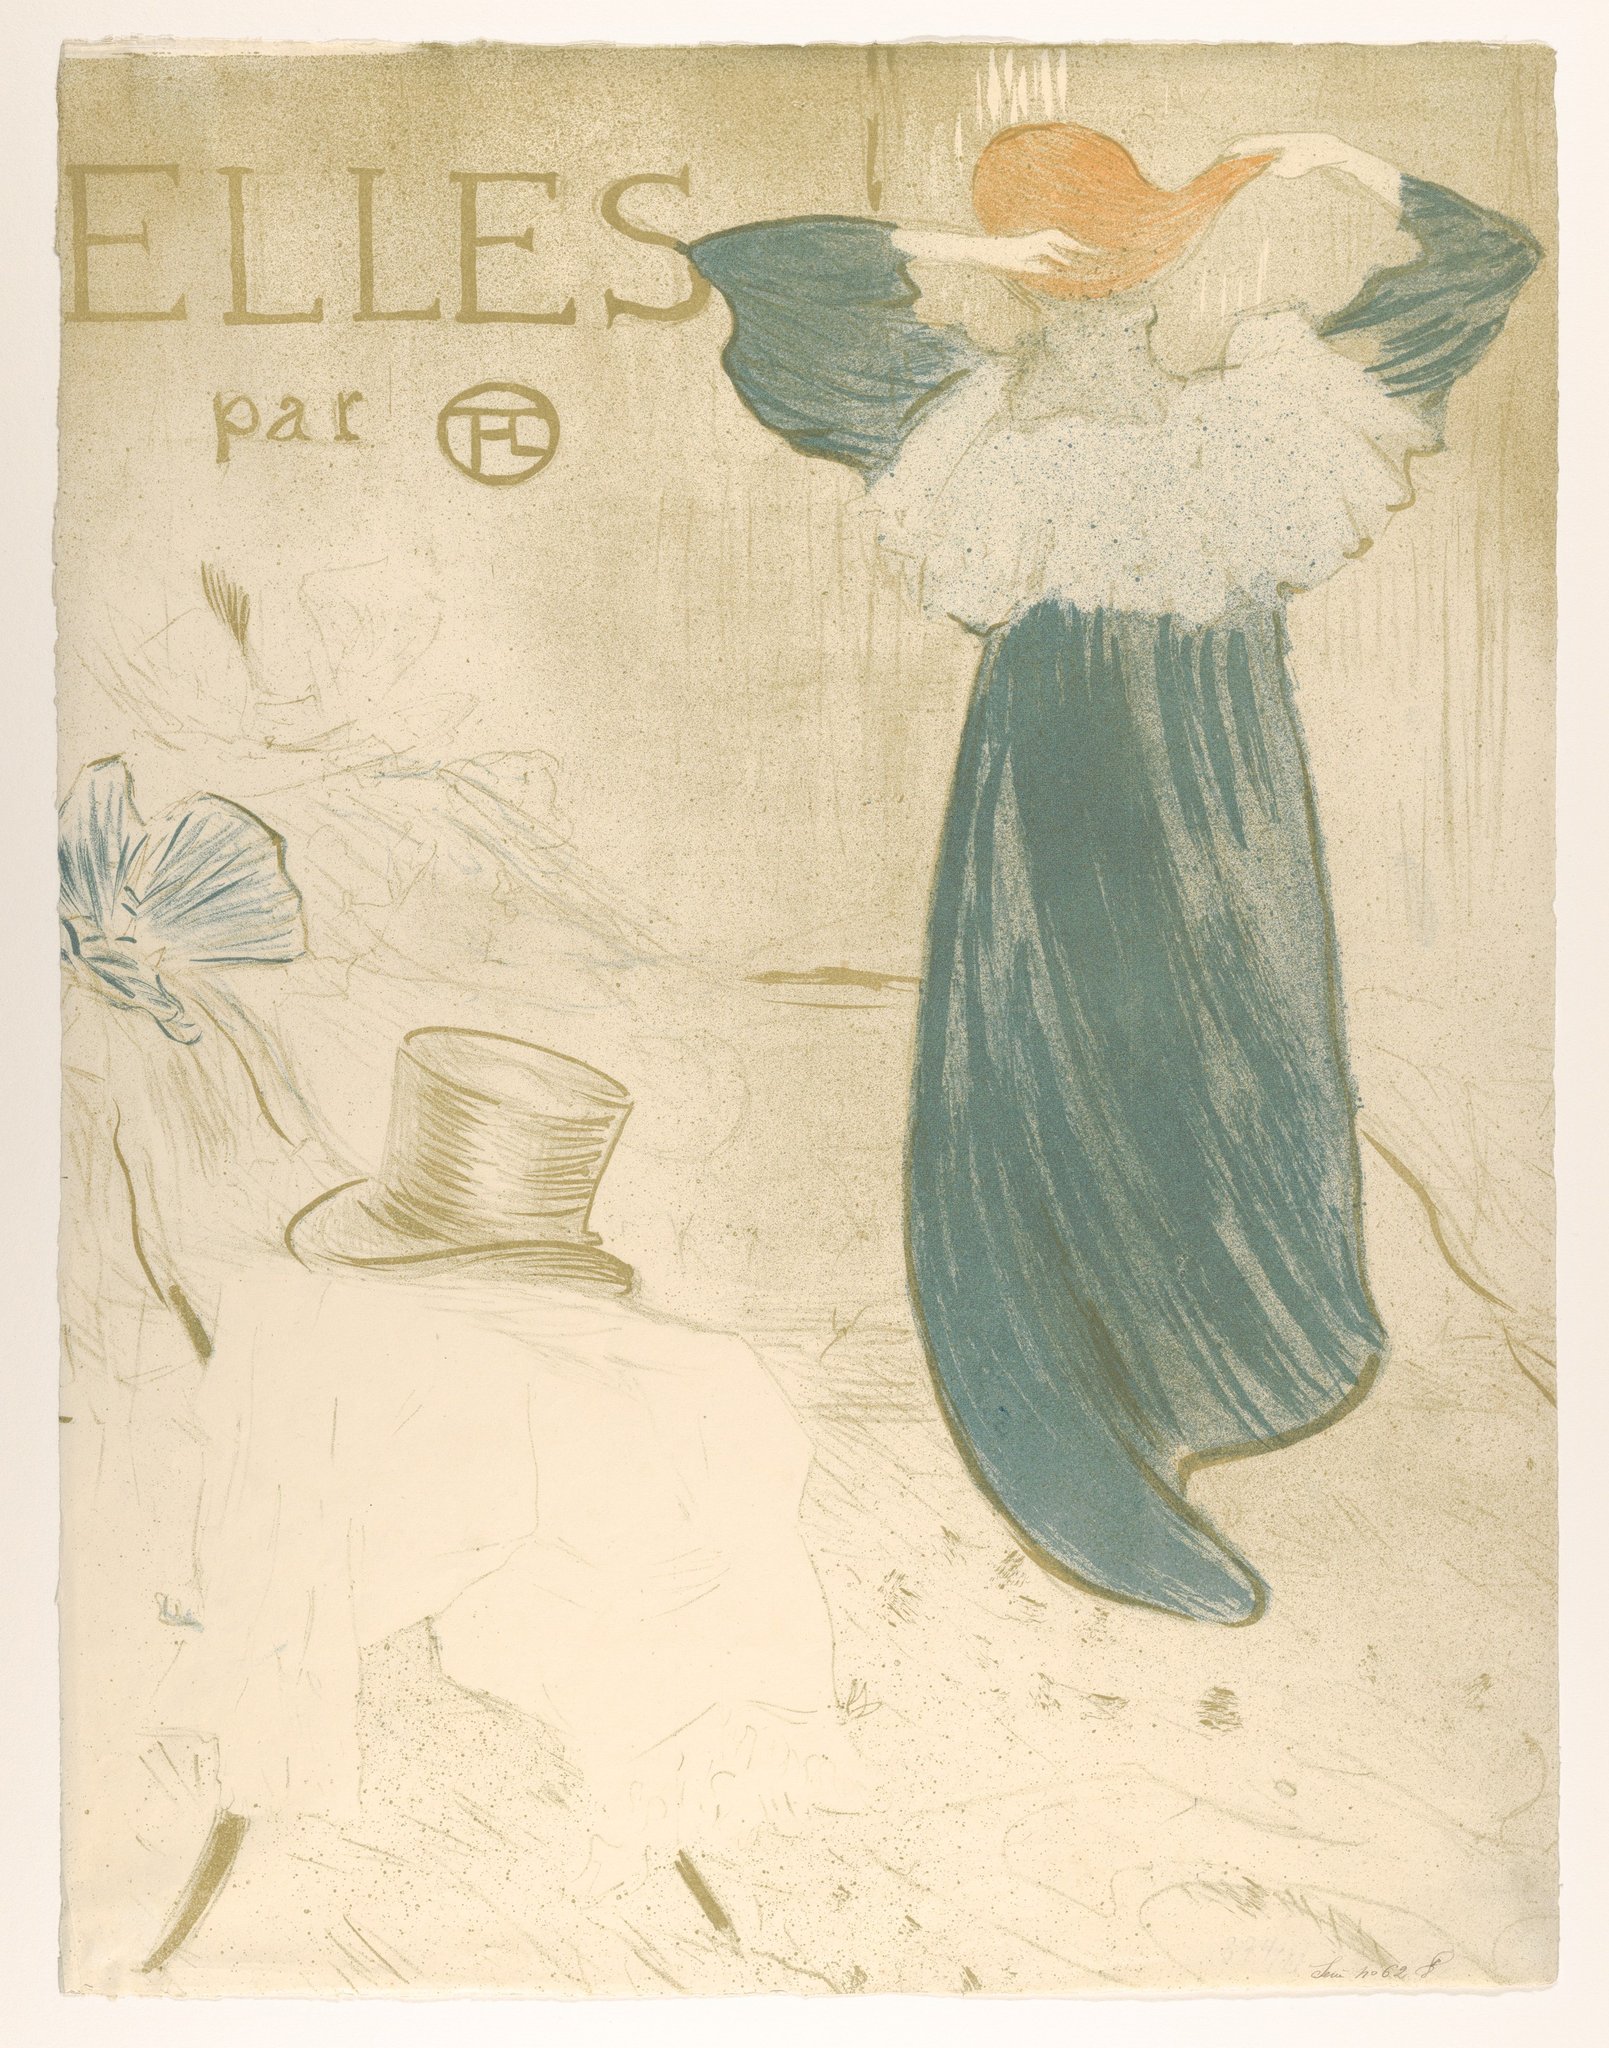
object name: print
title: Elles (portfolio cover)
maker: henri de toulouse-lautrec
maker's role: artist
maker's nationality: french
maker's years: 1864-1901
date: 1896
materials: crayon, paper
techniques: brush, lithograph, printing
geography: france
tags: hats,women